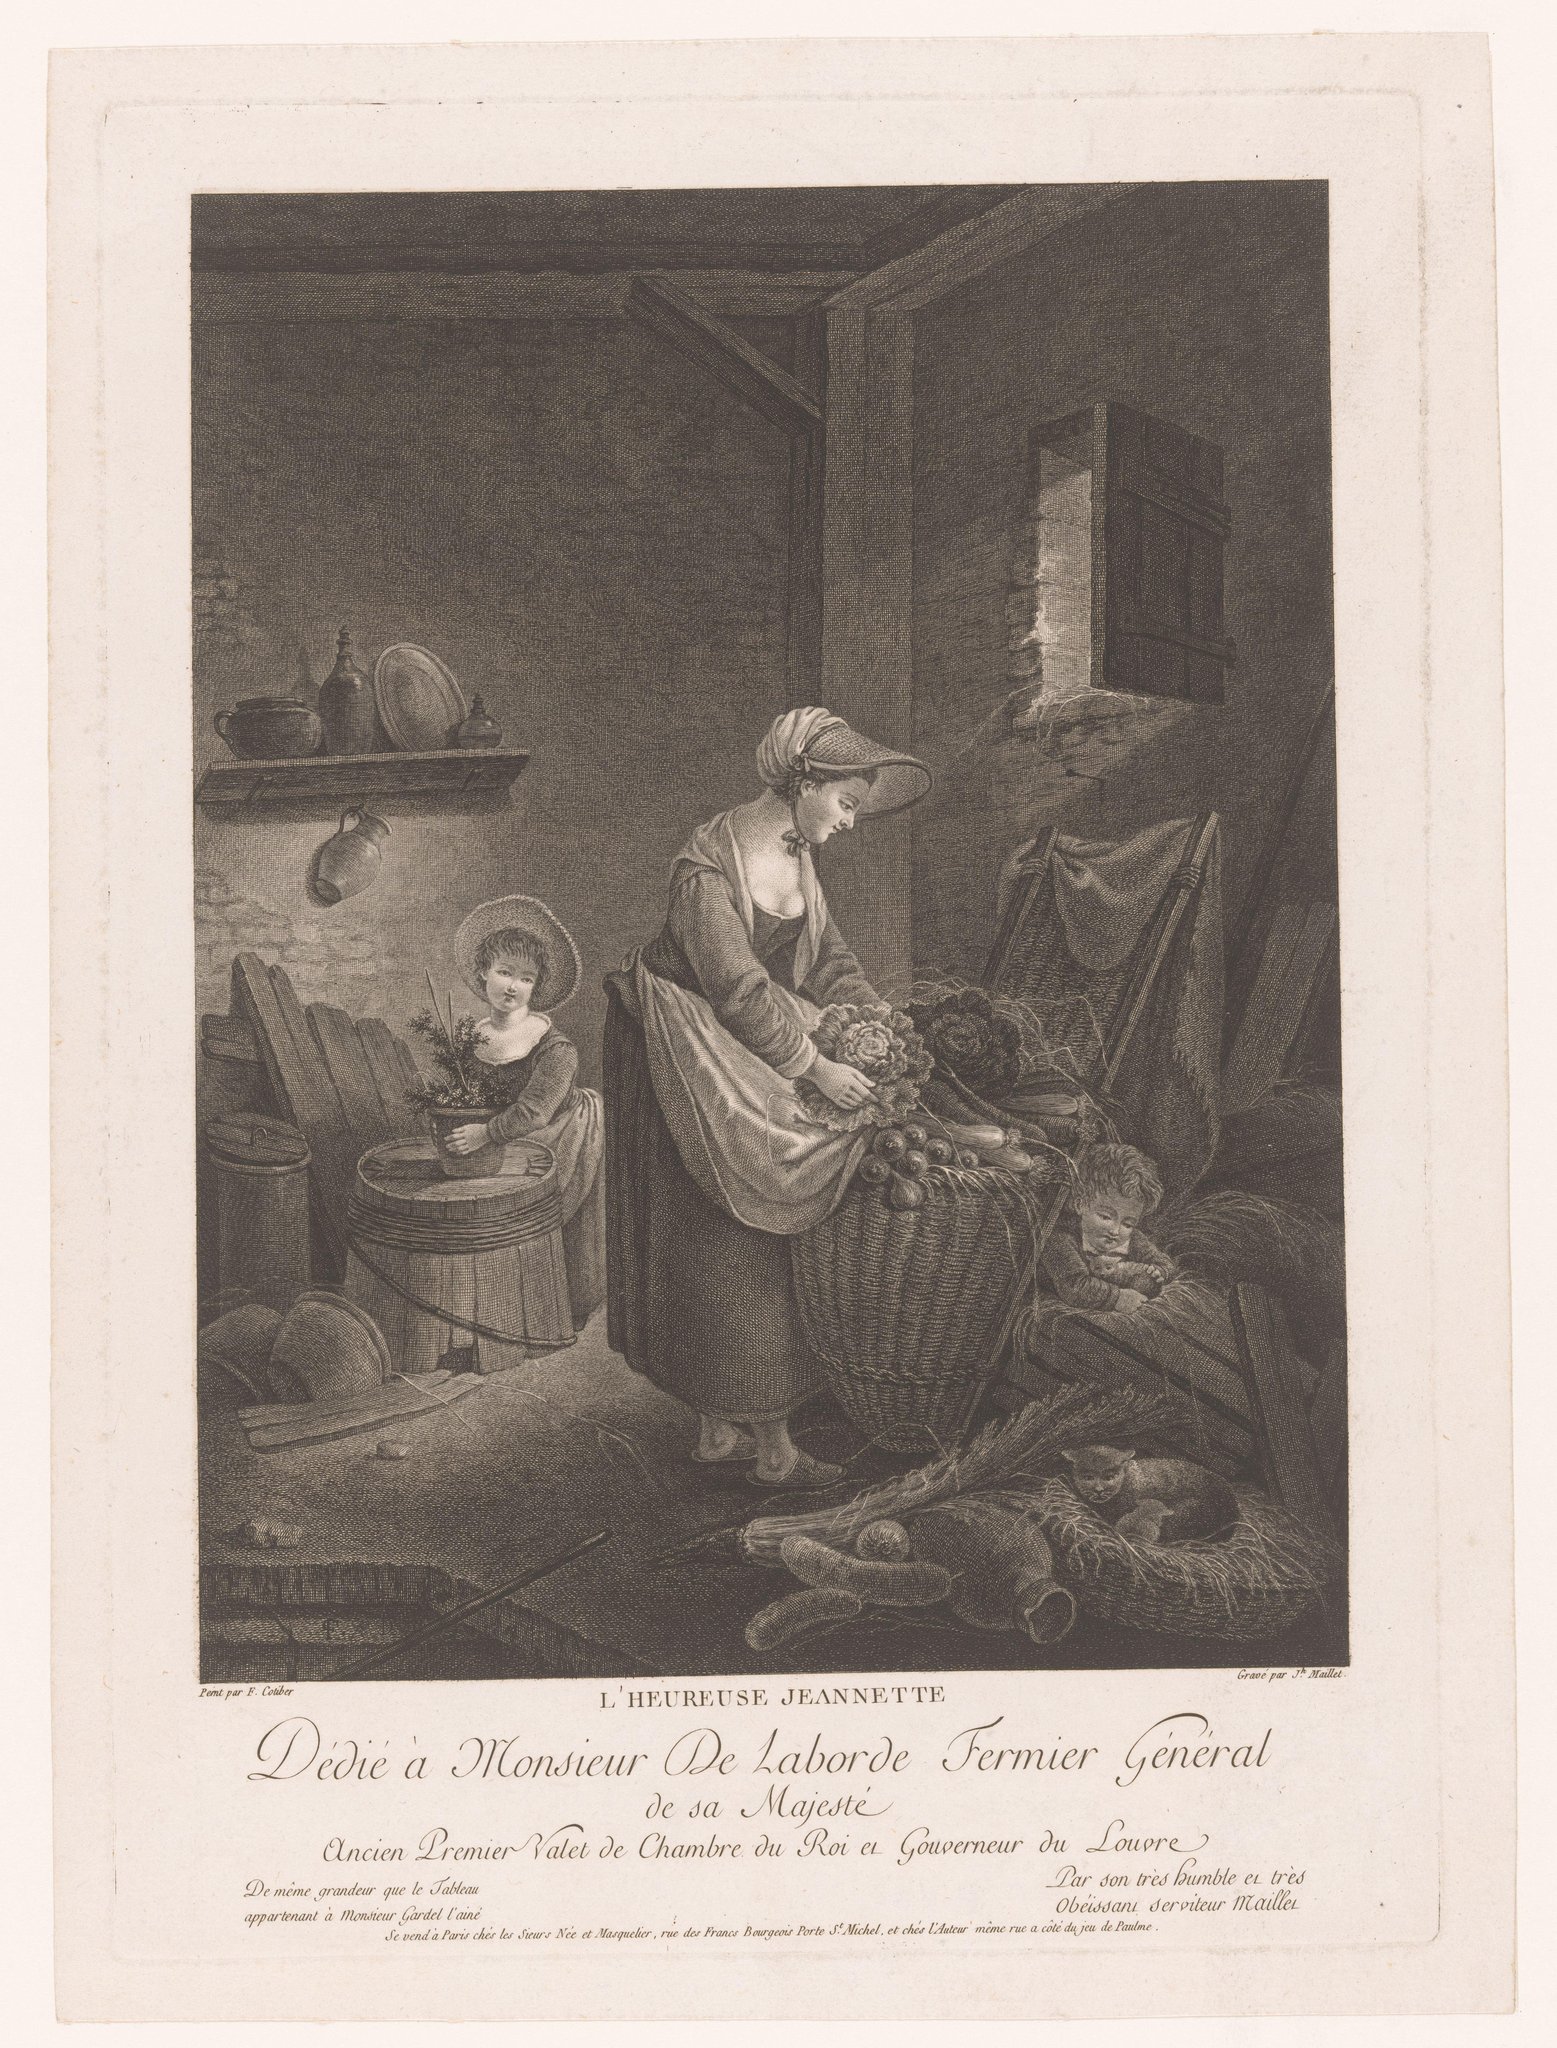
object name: print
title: L'heureuse Jeannette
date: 1761-1811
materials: paper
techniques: engraving, etching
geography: paris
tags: vegetables, cat, interior of the house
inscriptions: collector's mark: Lugt 2228